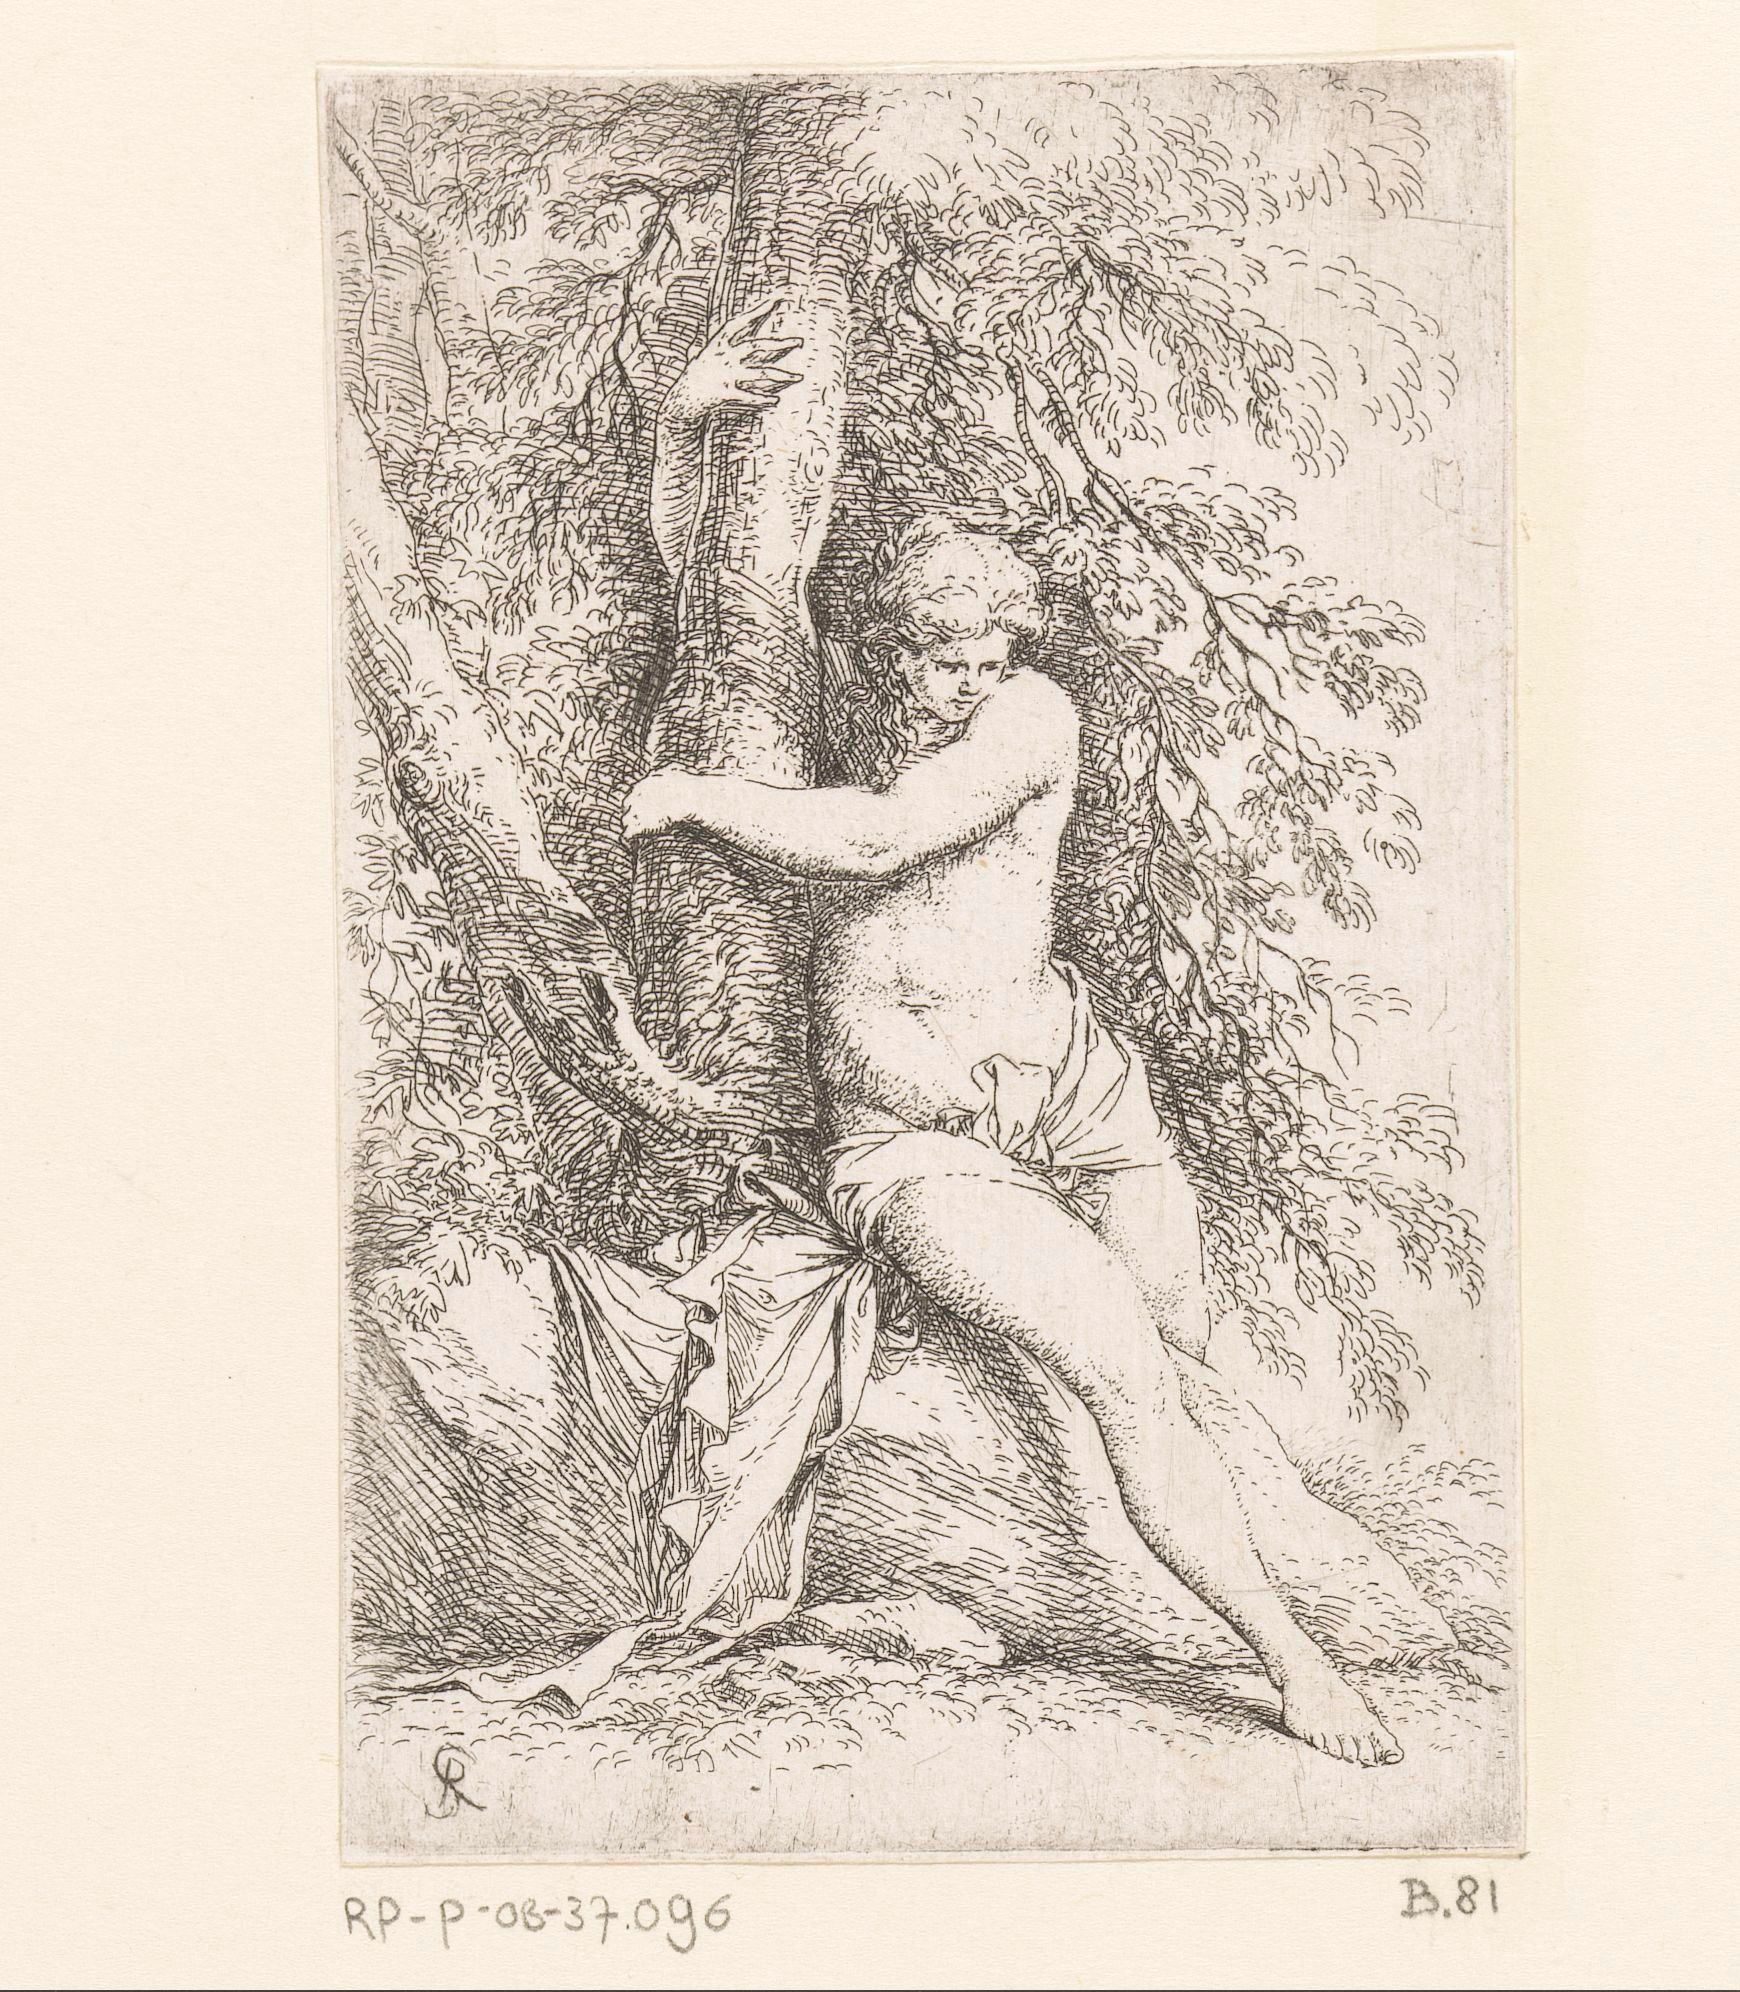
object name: print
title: Vrouw bij een boom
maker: salvator rosa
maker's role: draughtsman, painter, print maker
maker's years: 1615-1673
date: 1656-1657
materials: paper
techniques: drypoint, etching, intaglio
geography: italy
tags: woman (showing herself) undressed, quasi-nude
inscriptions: collector's mark: Lugt 240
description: Prent spiegelbeeldig naar een tekening in de British Museum te Londen. Deze prent maakt deel uit van de serie 'Figurine', bestaande uit een titelprent en 80 prenten van klein formaat met voorstellingen van mannelijke en vrouwelijke figuren. Rosa produceerde de serie waarschijnlijk gedurende de jaren 1656 en 1657.